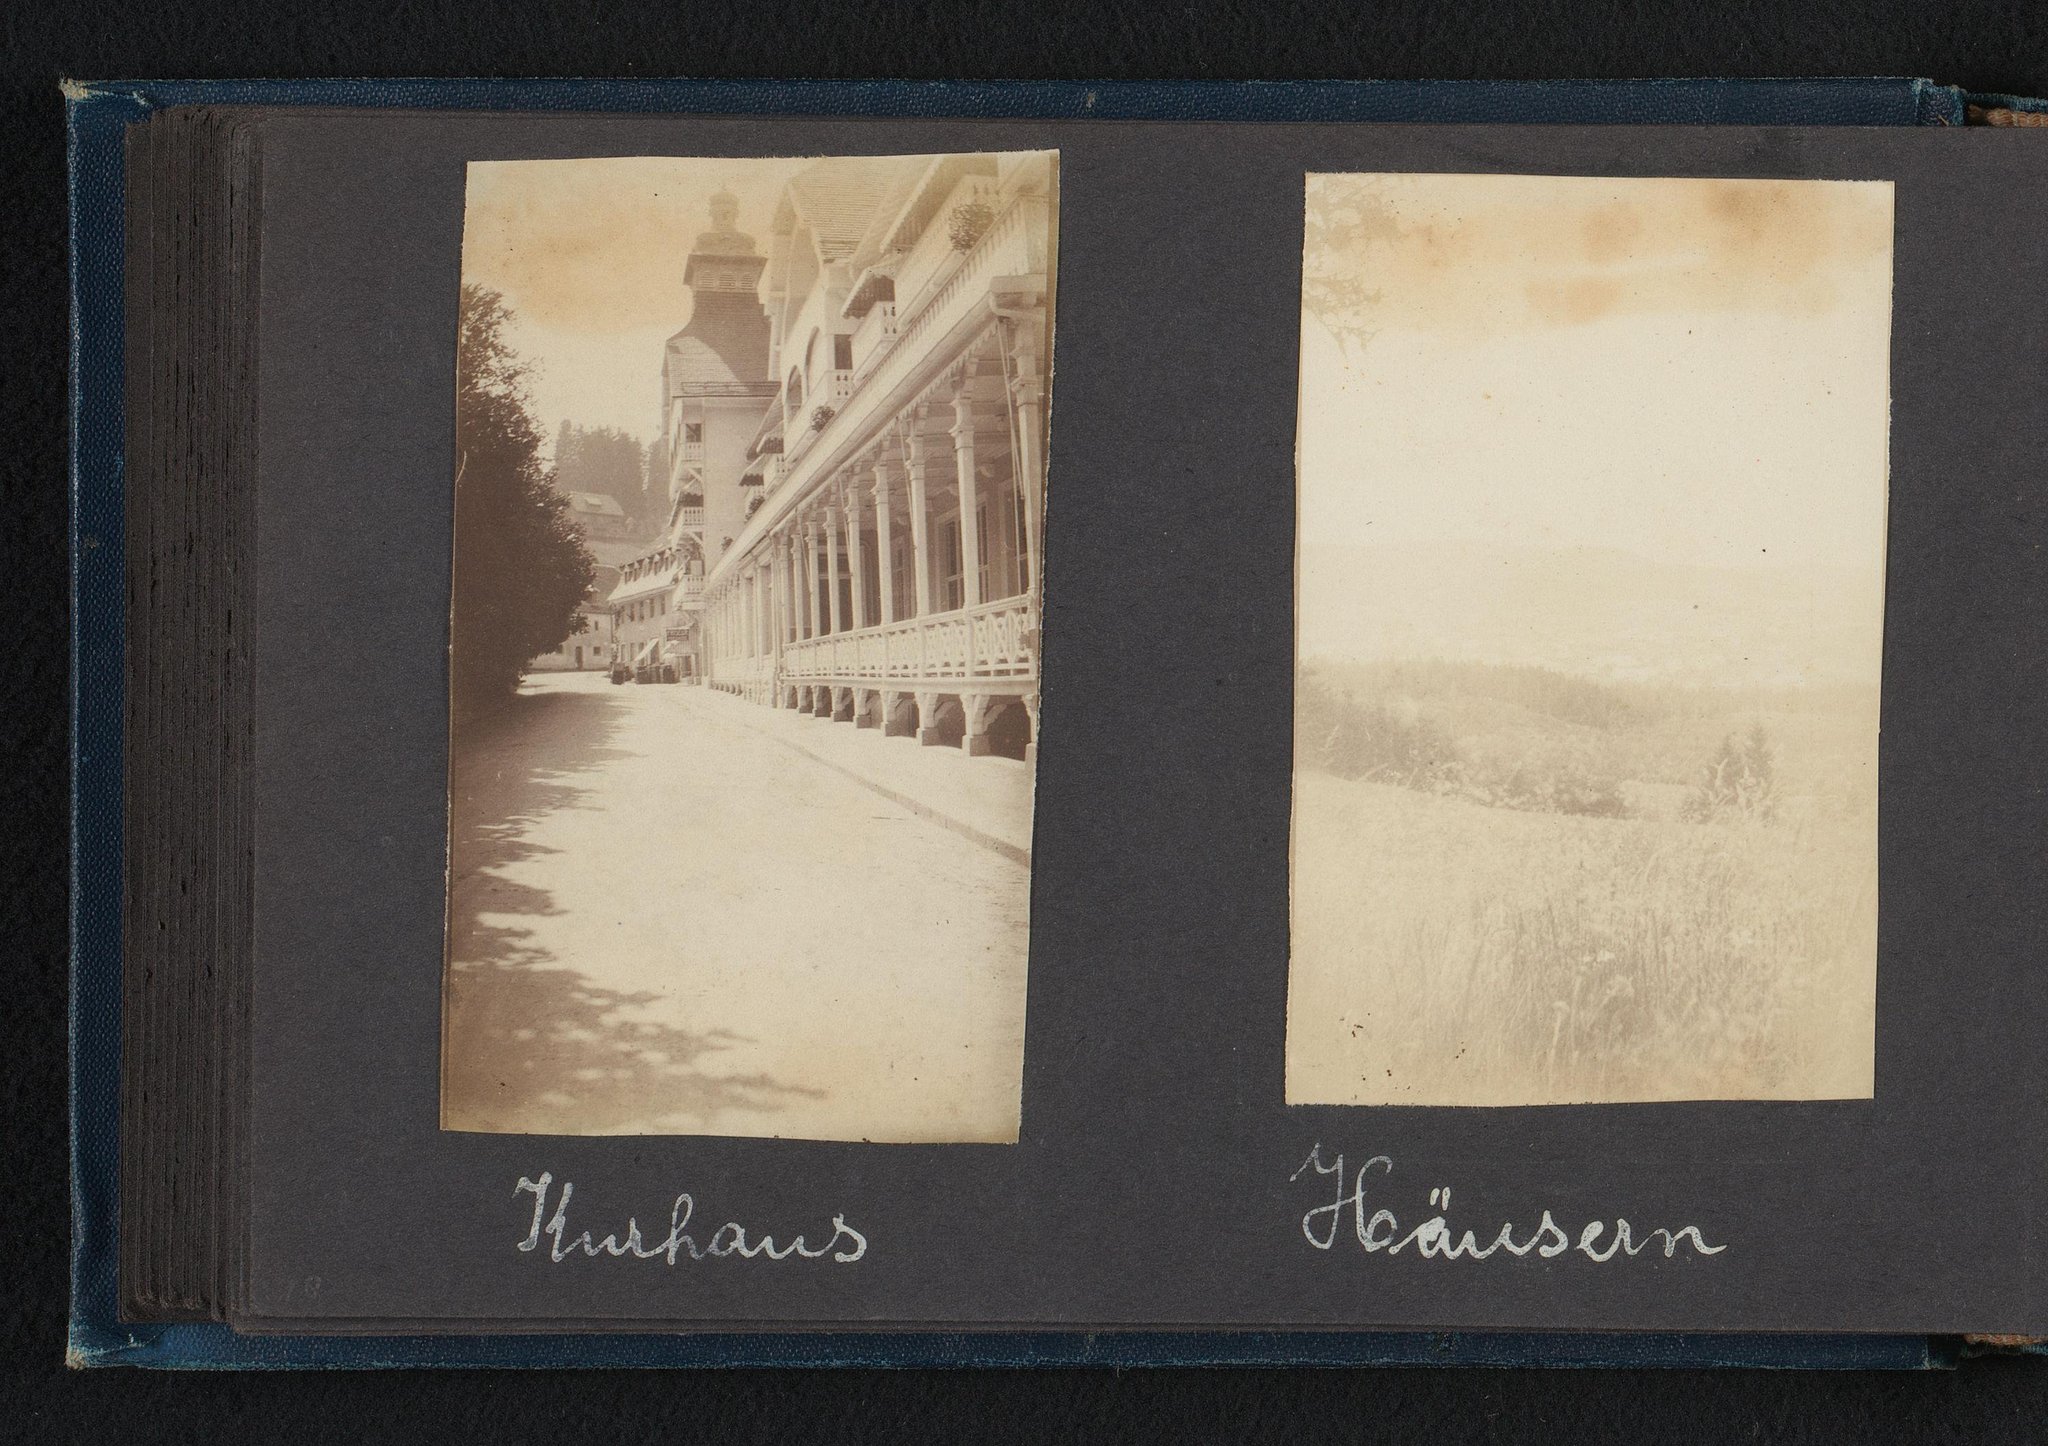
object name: photograph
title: Kurhaus en landschap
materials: paper, photographic support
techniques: salted paper print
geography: germany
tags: else wachenheimer-moos, low hill country, watering-place, spa, germany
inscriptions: inscription: ‘Kurhaus / Häusern’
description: Albumblad met twee foto's van het Kurhaus in St. Blasien en van een landschap bij Häusern. Onderdeel van het fotoalbum van Else Wachenheimer-Moos en haar broers Arthur en Willy Moos en anderen in de periode 1913-1918.